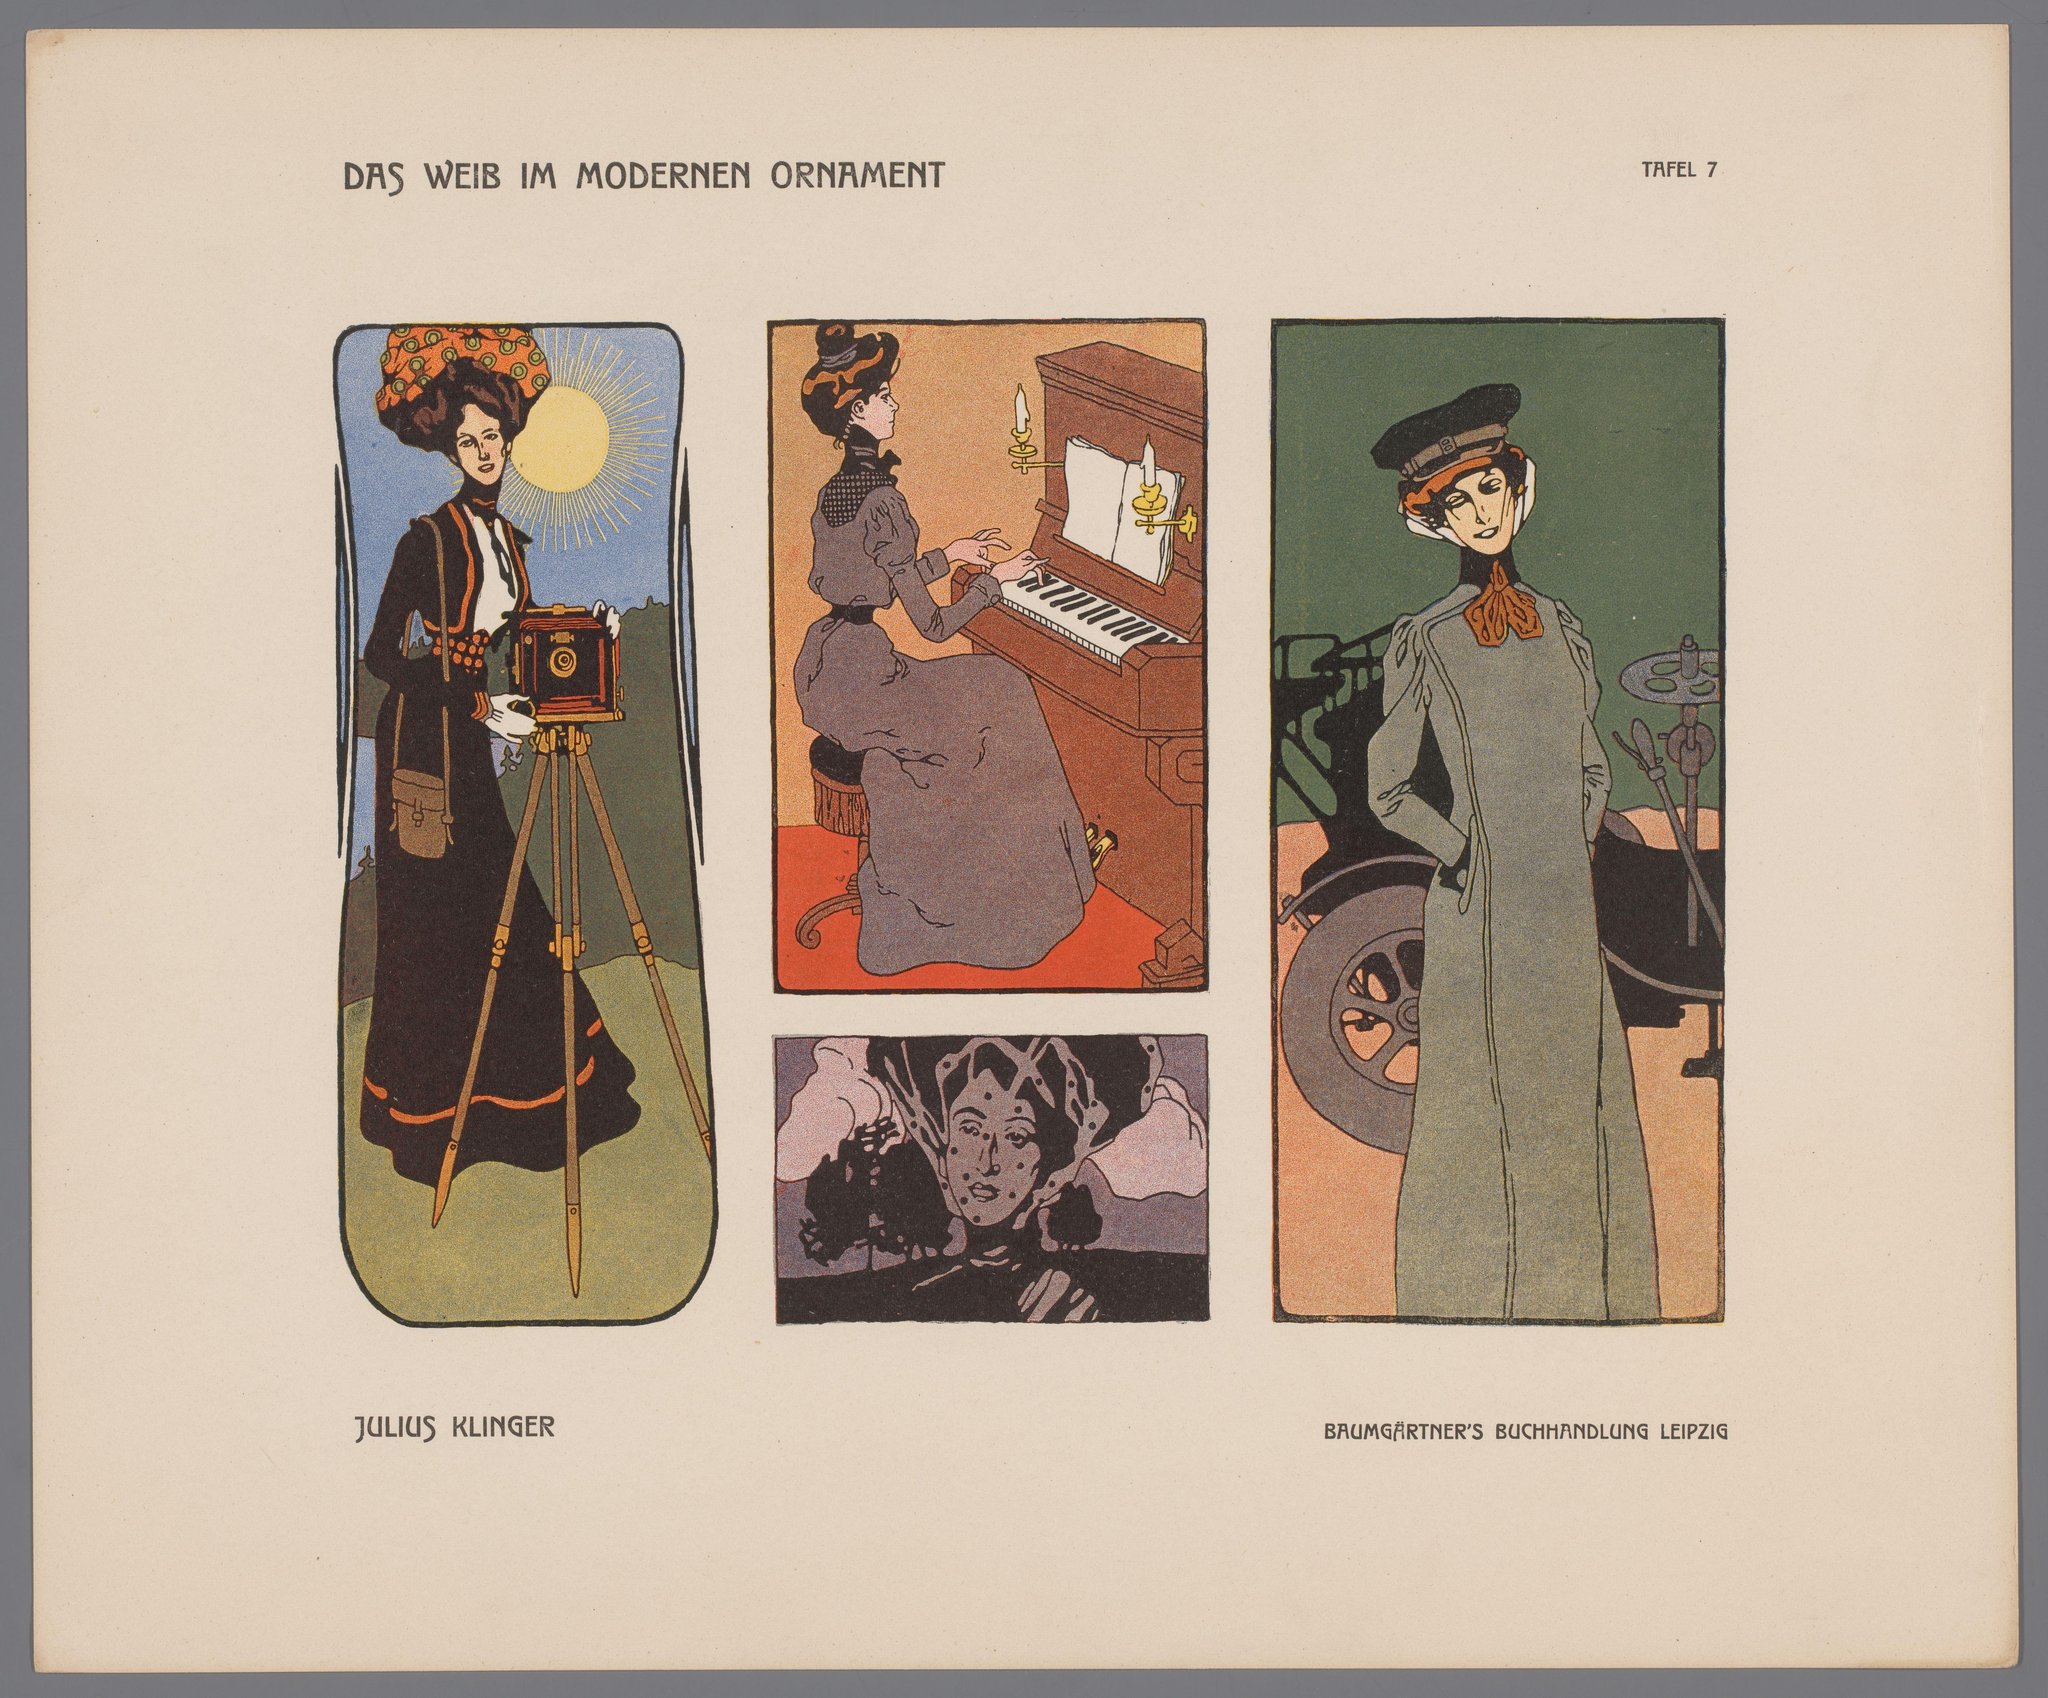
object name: photomechanical print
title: Reproductie van vier lithografieën van onder andere een vrouw met een camera door Julius Klinger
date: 1902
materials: paper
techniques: lithograph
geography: leipzig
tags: adult woman, camera ~ photography, pianoforte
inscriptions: inscription: ‘TAFEL 7’